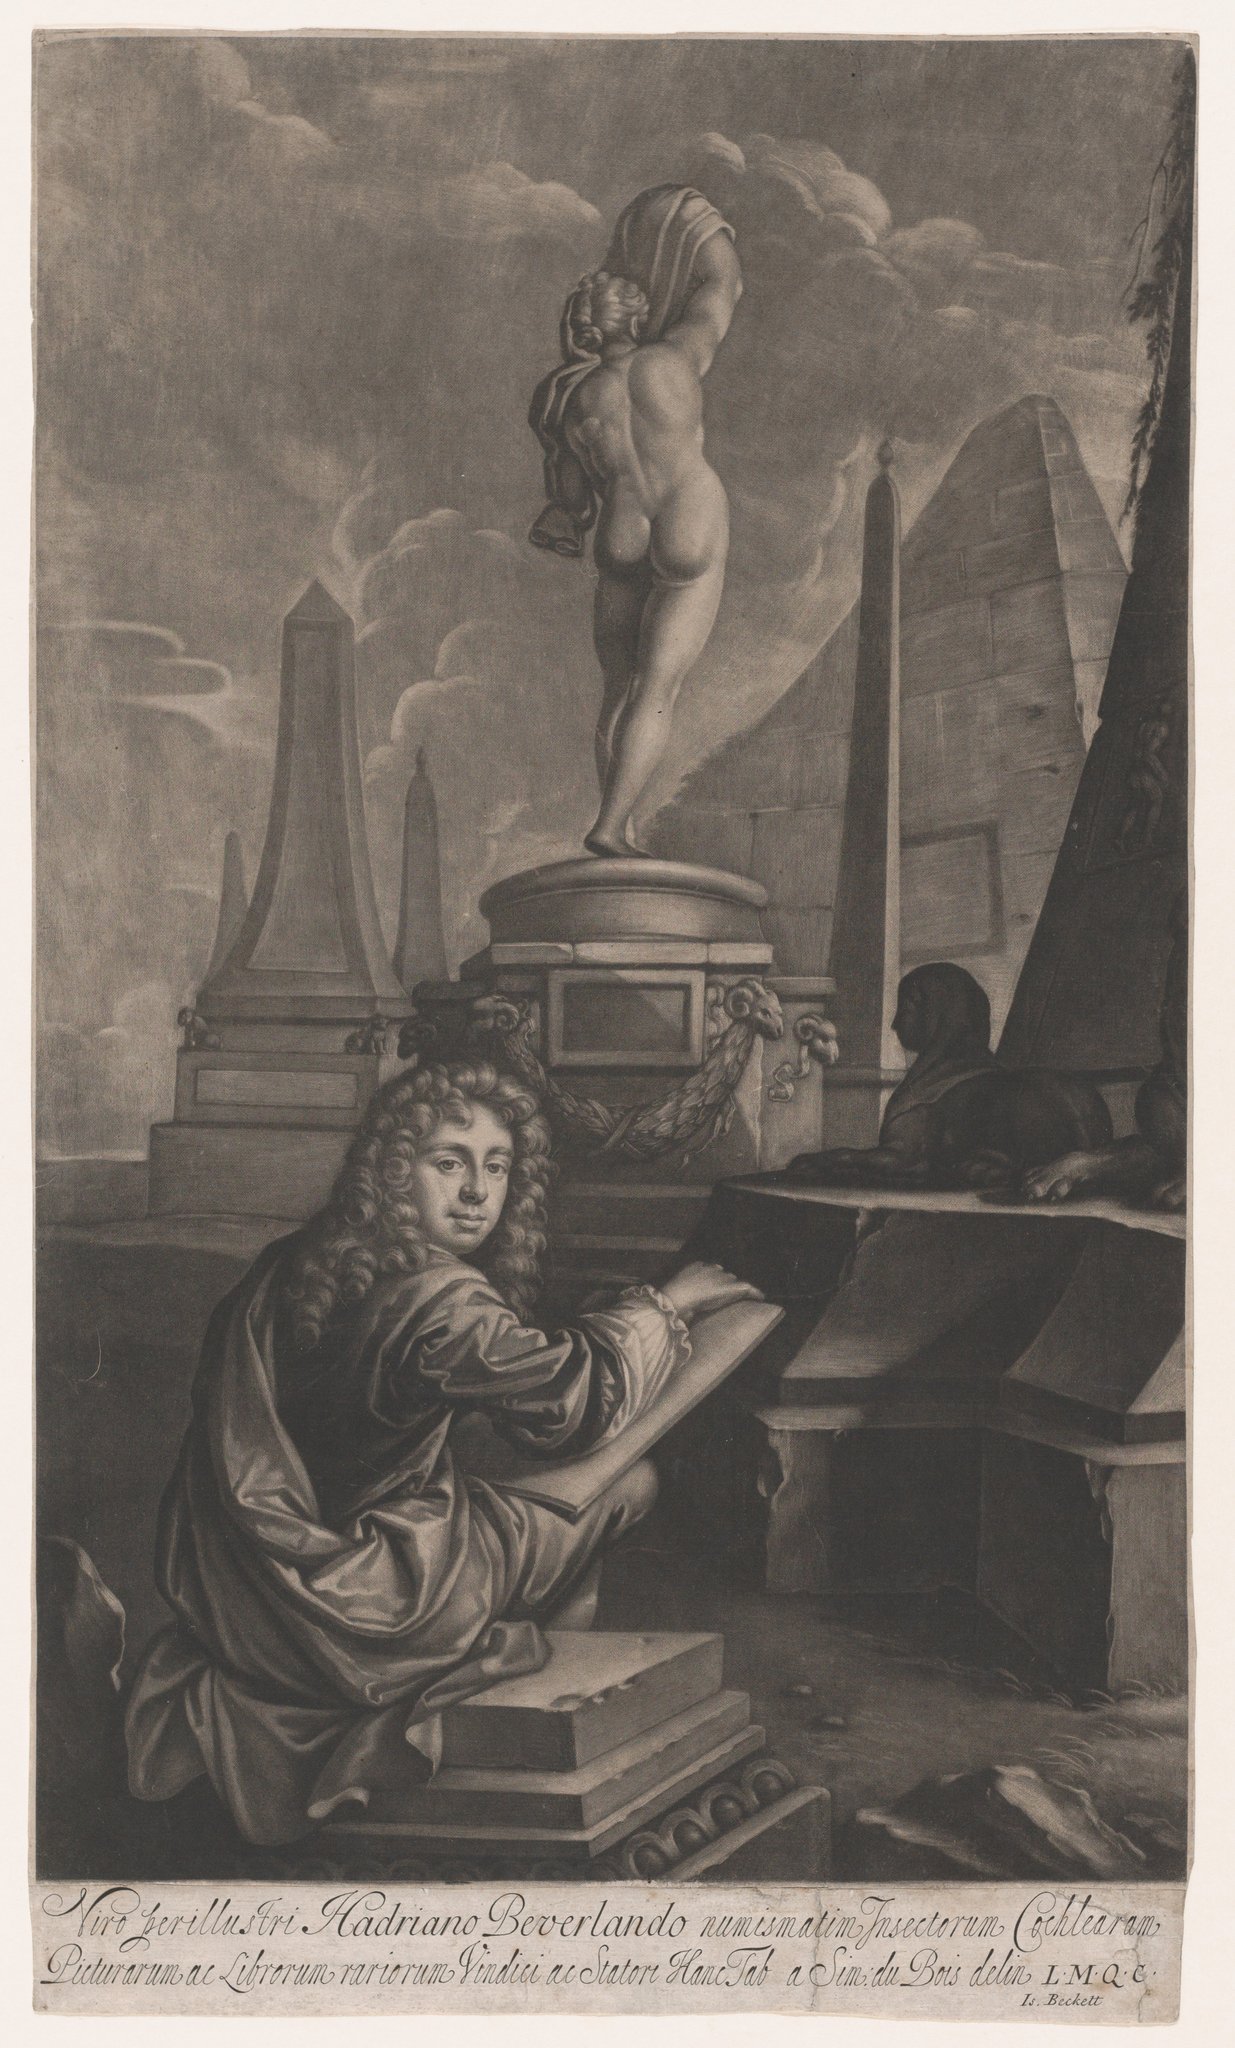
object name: print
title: Portrait of Hadriaan Beverland Drawing a Sculpture of the Callipygian Venus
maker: isaac beckett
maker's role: artist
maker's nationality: british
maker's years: 1653-1719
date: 1686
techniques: mezzotint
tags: drawing,obelisks,men,portraits,venus